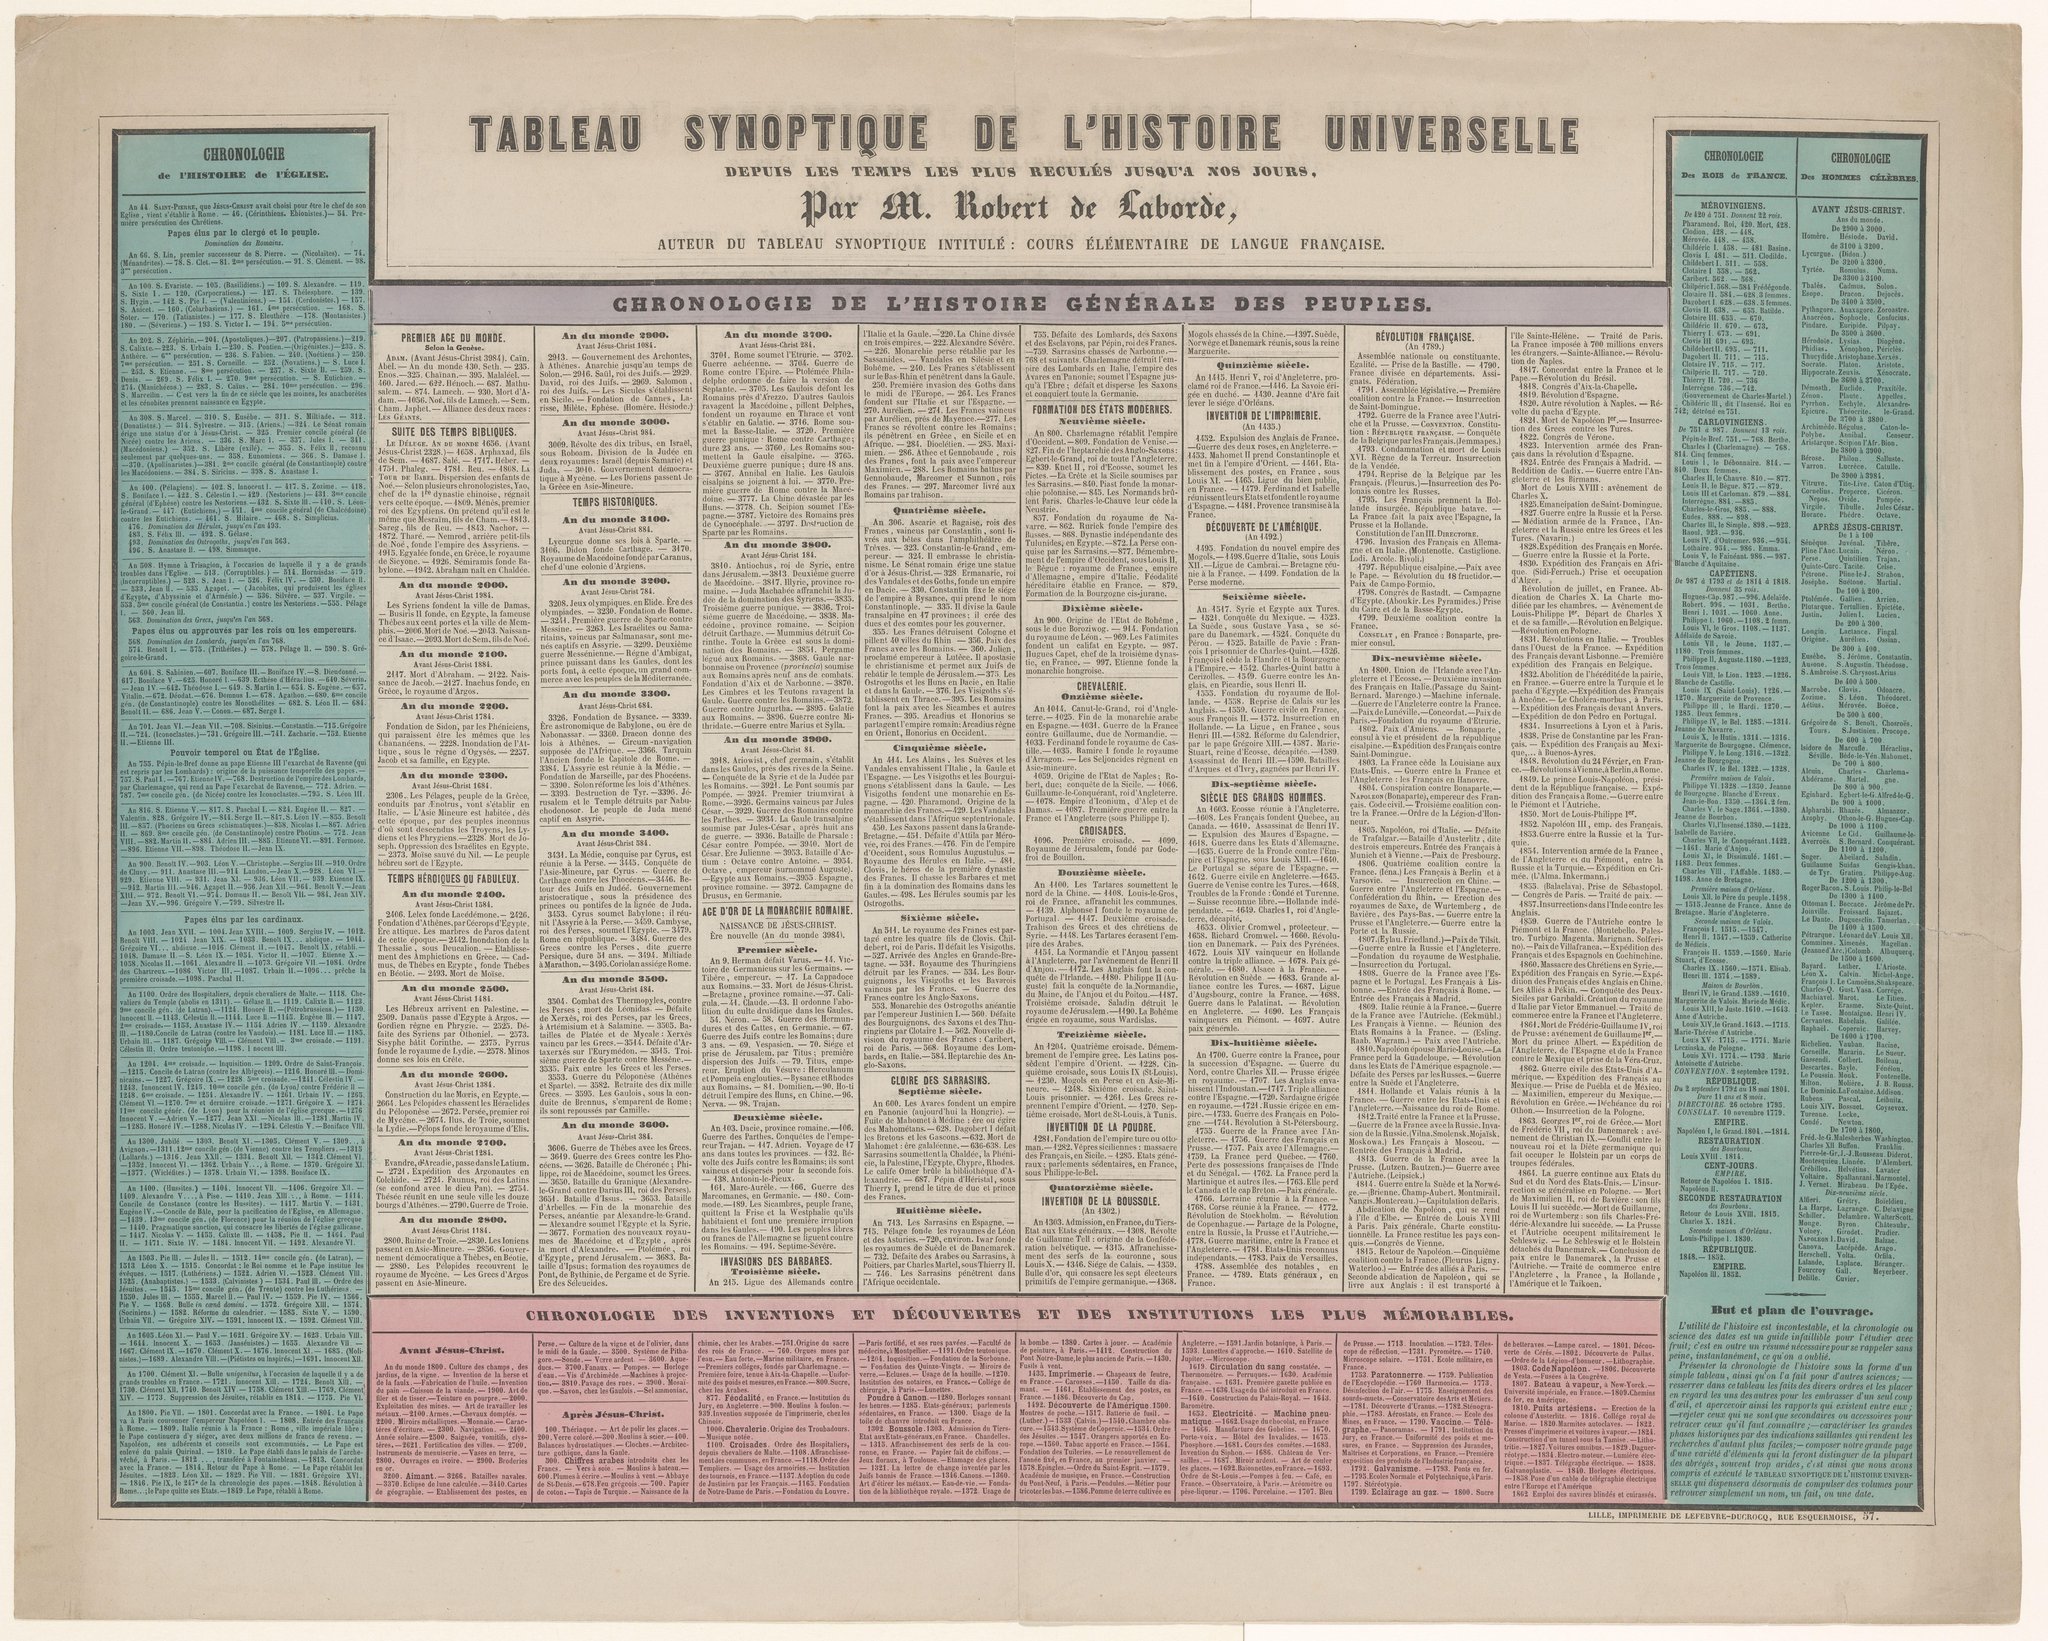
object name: text sheet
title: Tijdtabel van geschiedenis vanaf Adam tot 1864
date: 1864-1865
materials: paper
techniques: printing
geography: lille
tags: statistic diagram, graph; pictorial chart, etc., historical events and situations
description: Tijdtabel van universele geschiedenis vanaf Adam (3984 v. Chr.) tot in 1864 (Amerikaanse Burgeroorlog). Dubbelgevouwen blad met verschillende chronologieën en overzichten in verschillende kleuren.